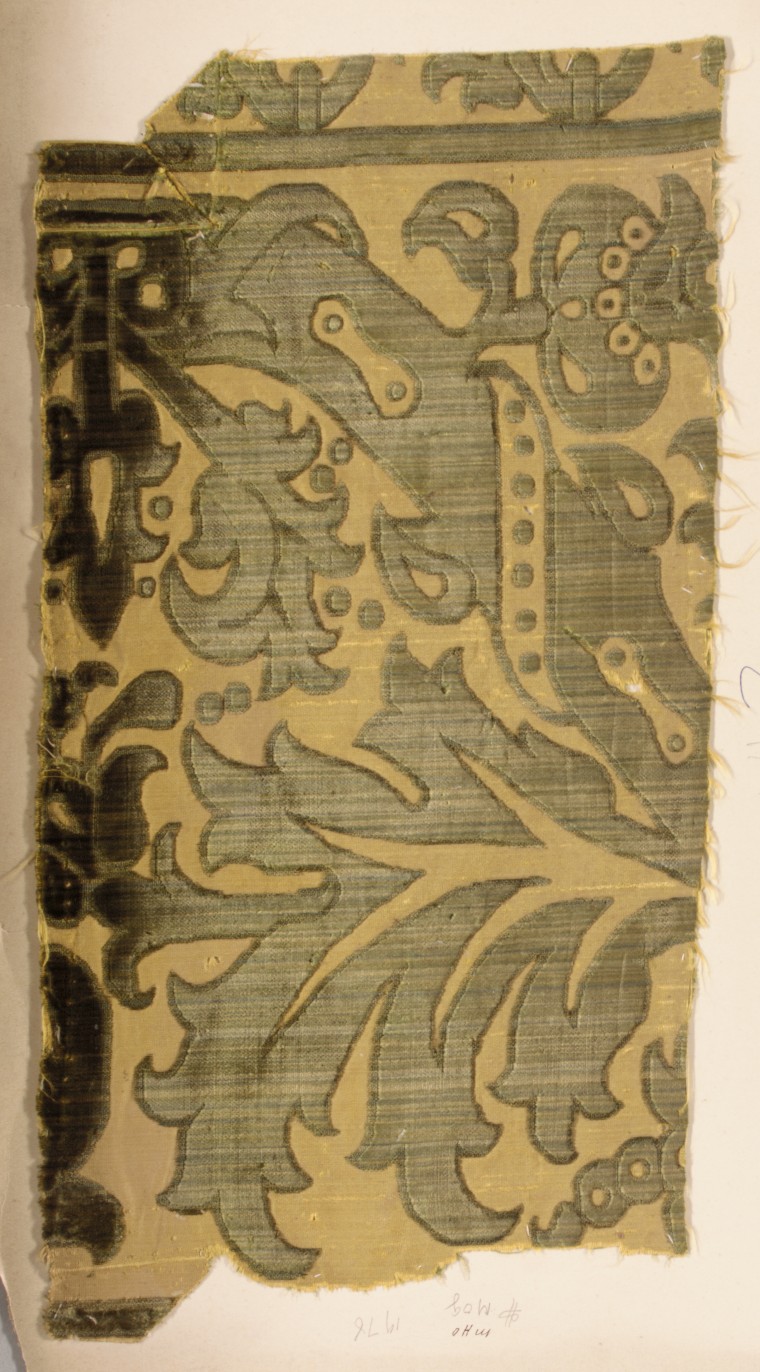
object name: fragment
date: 1601-1700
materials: silk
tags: leaves